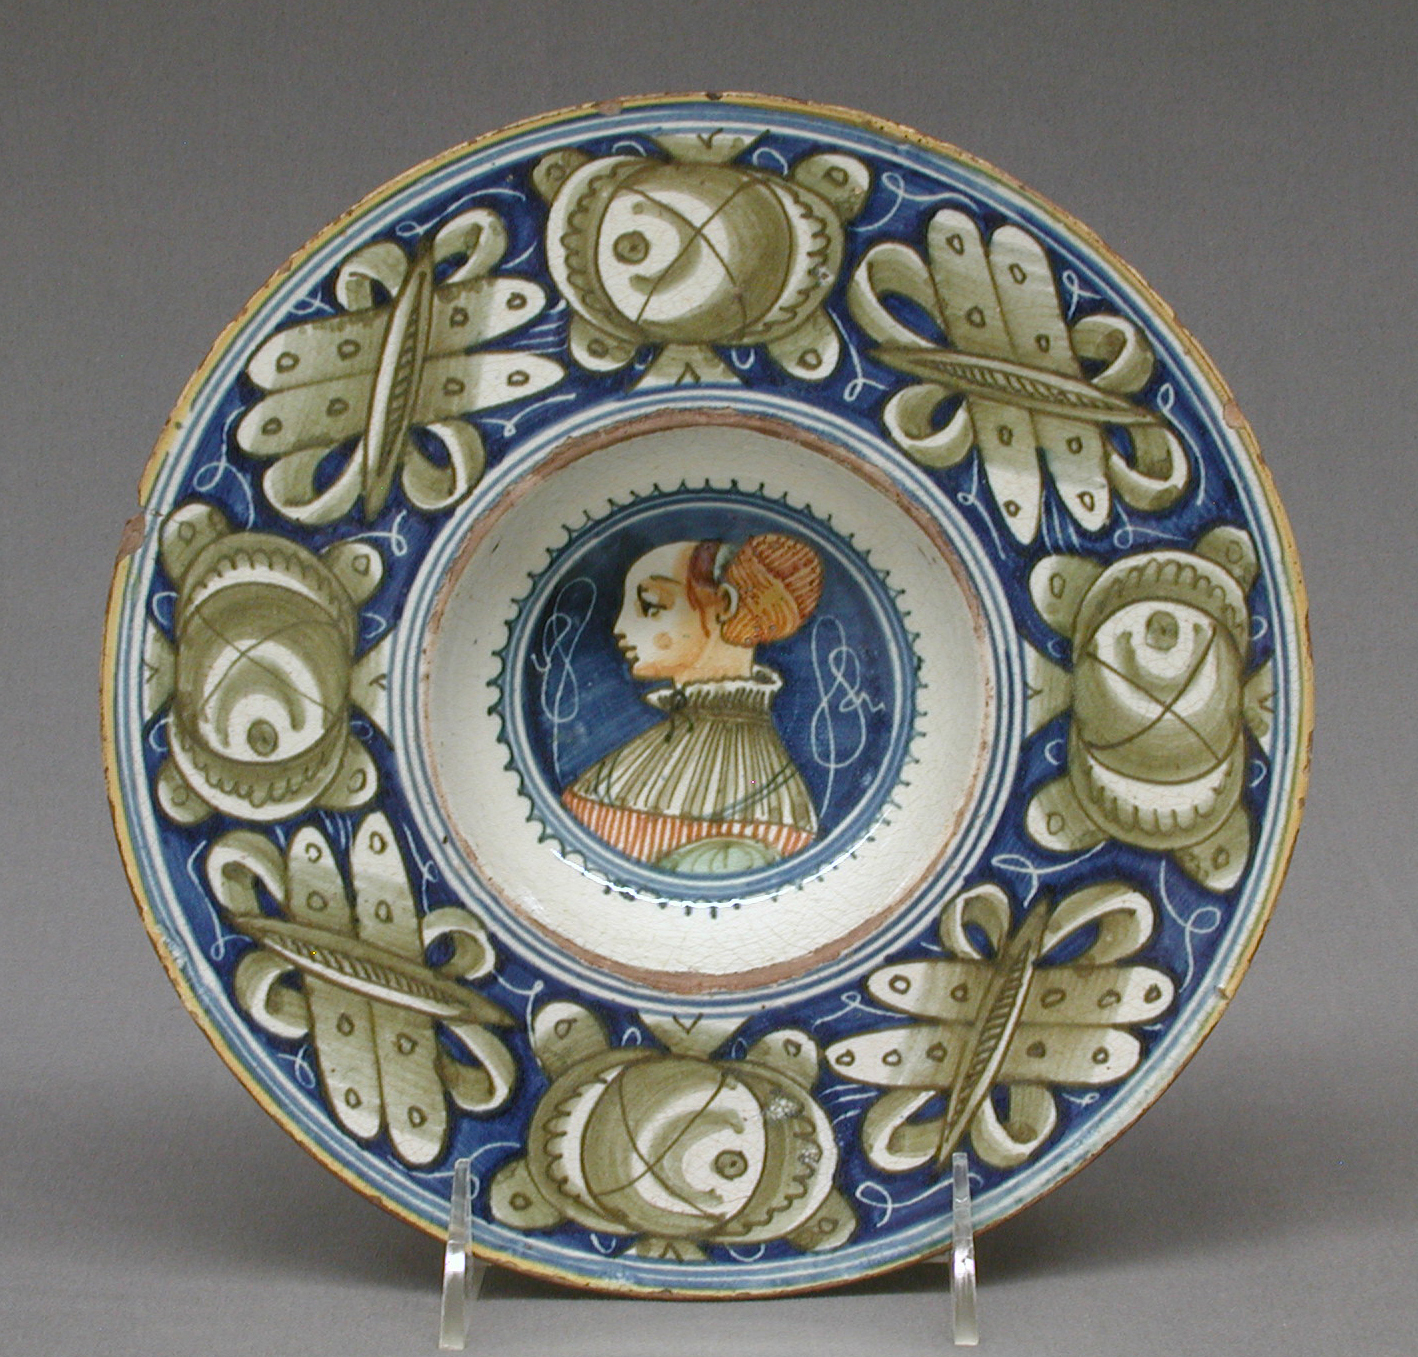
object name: dish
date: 1501-1600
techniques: maiolica, glazing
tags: profiles